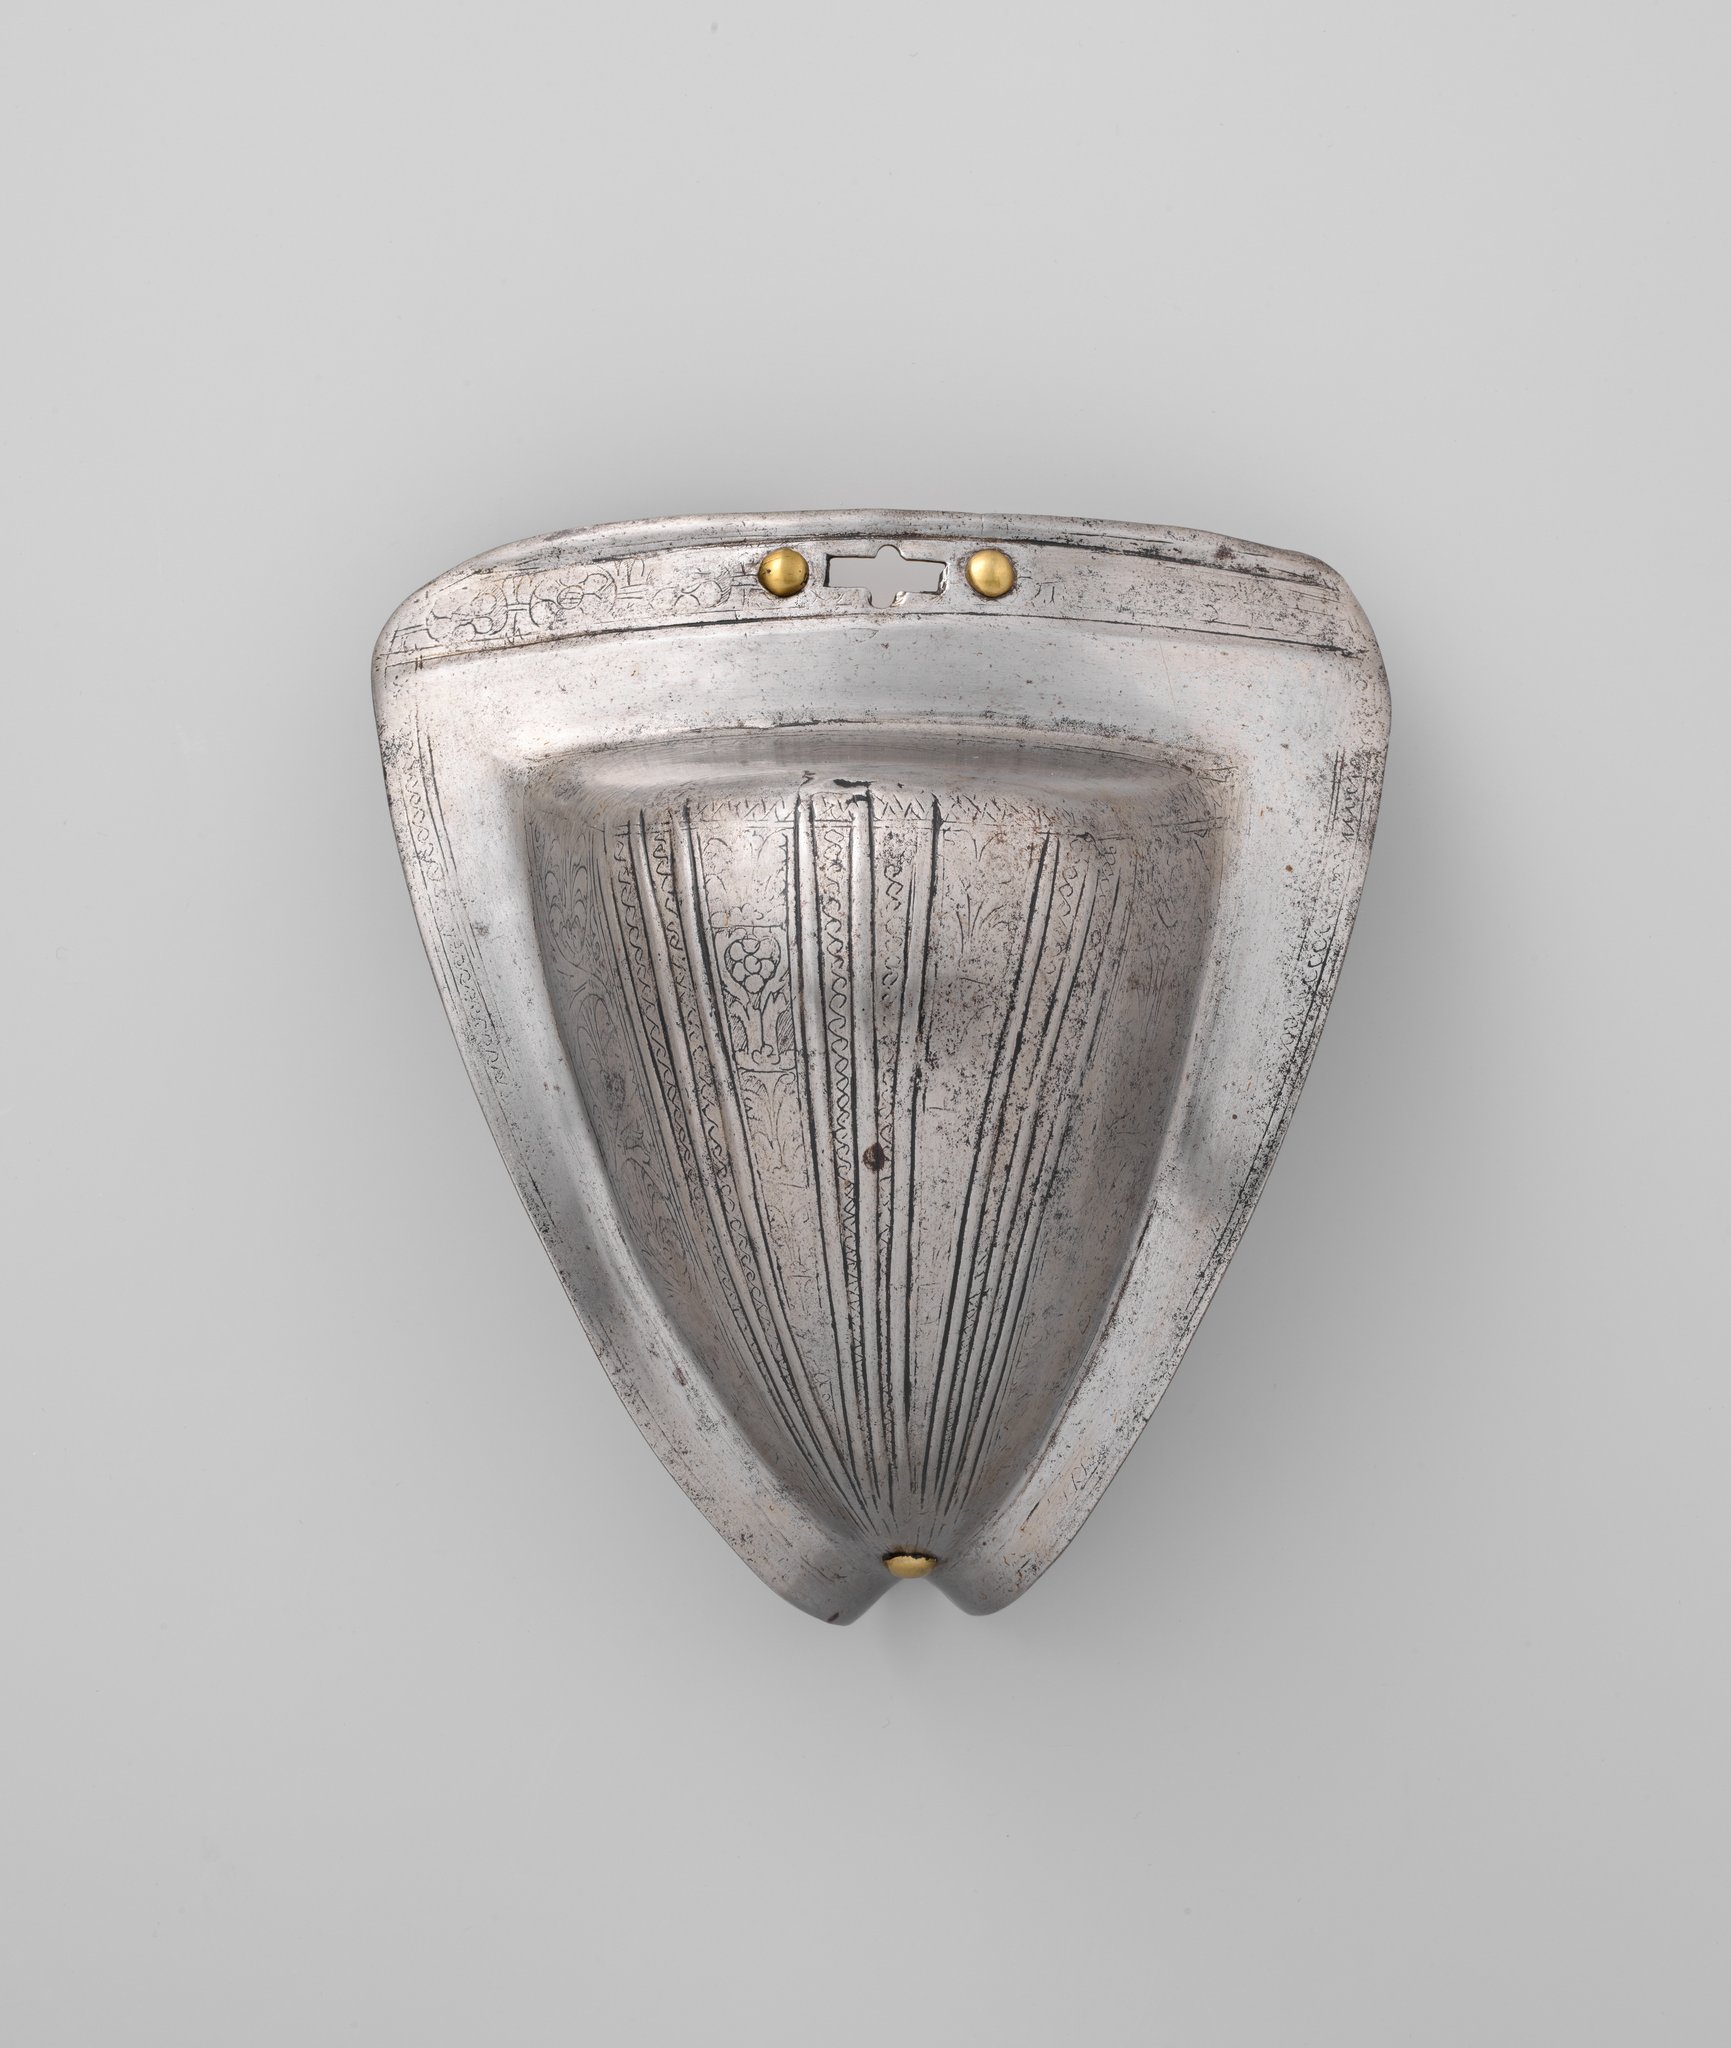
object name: brayette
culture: italian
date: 1510-1515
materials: copper alloy, steel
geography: italy